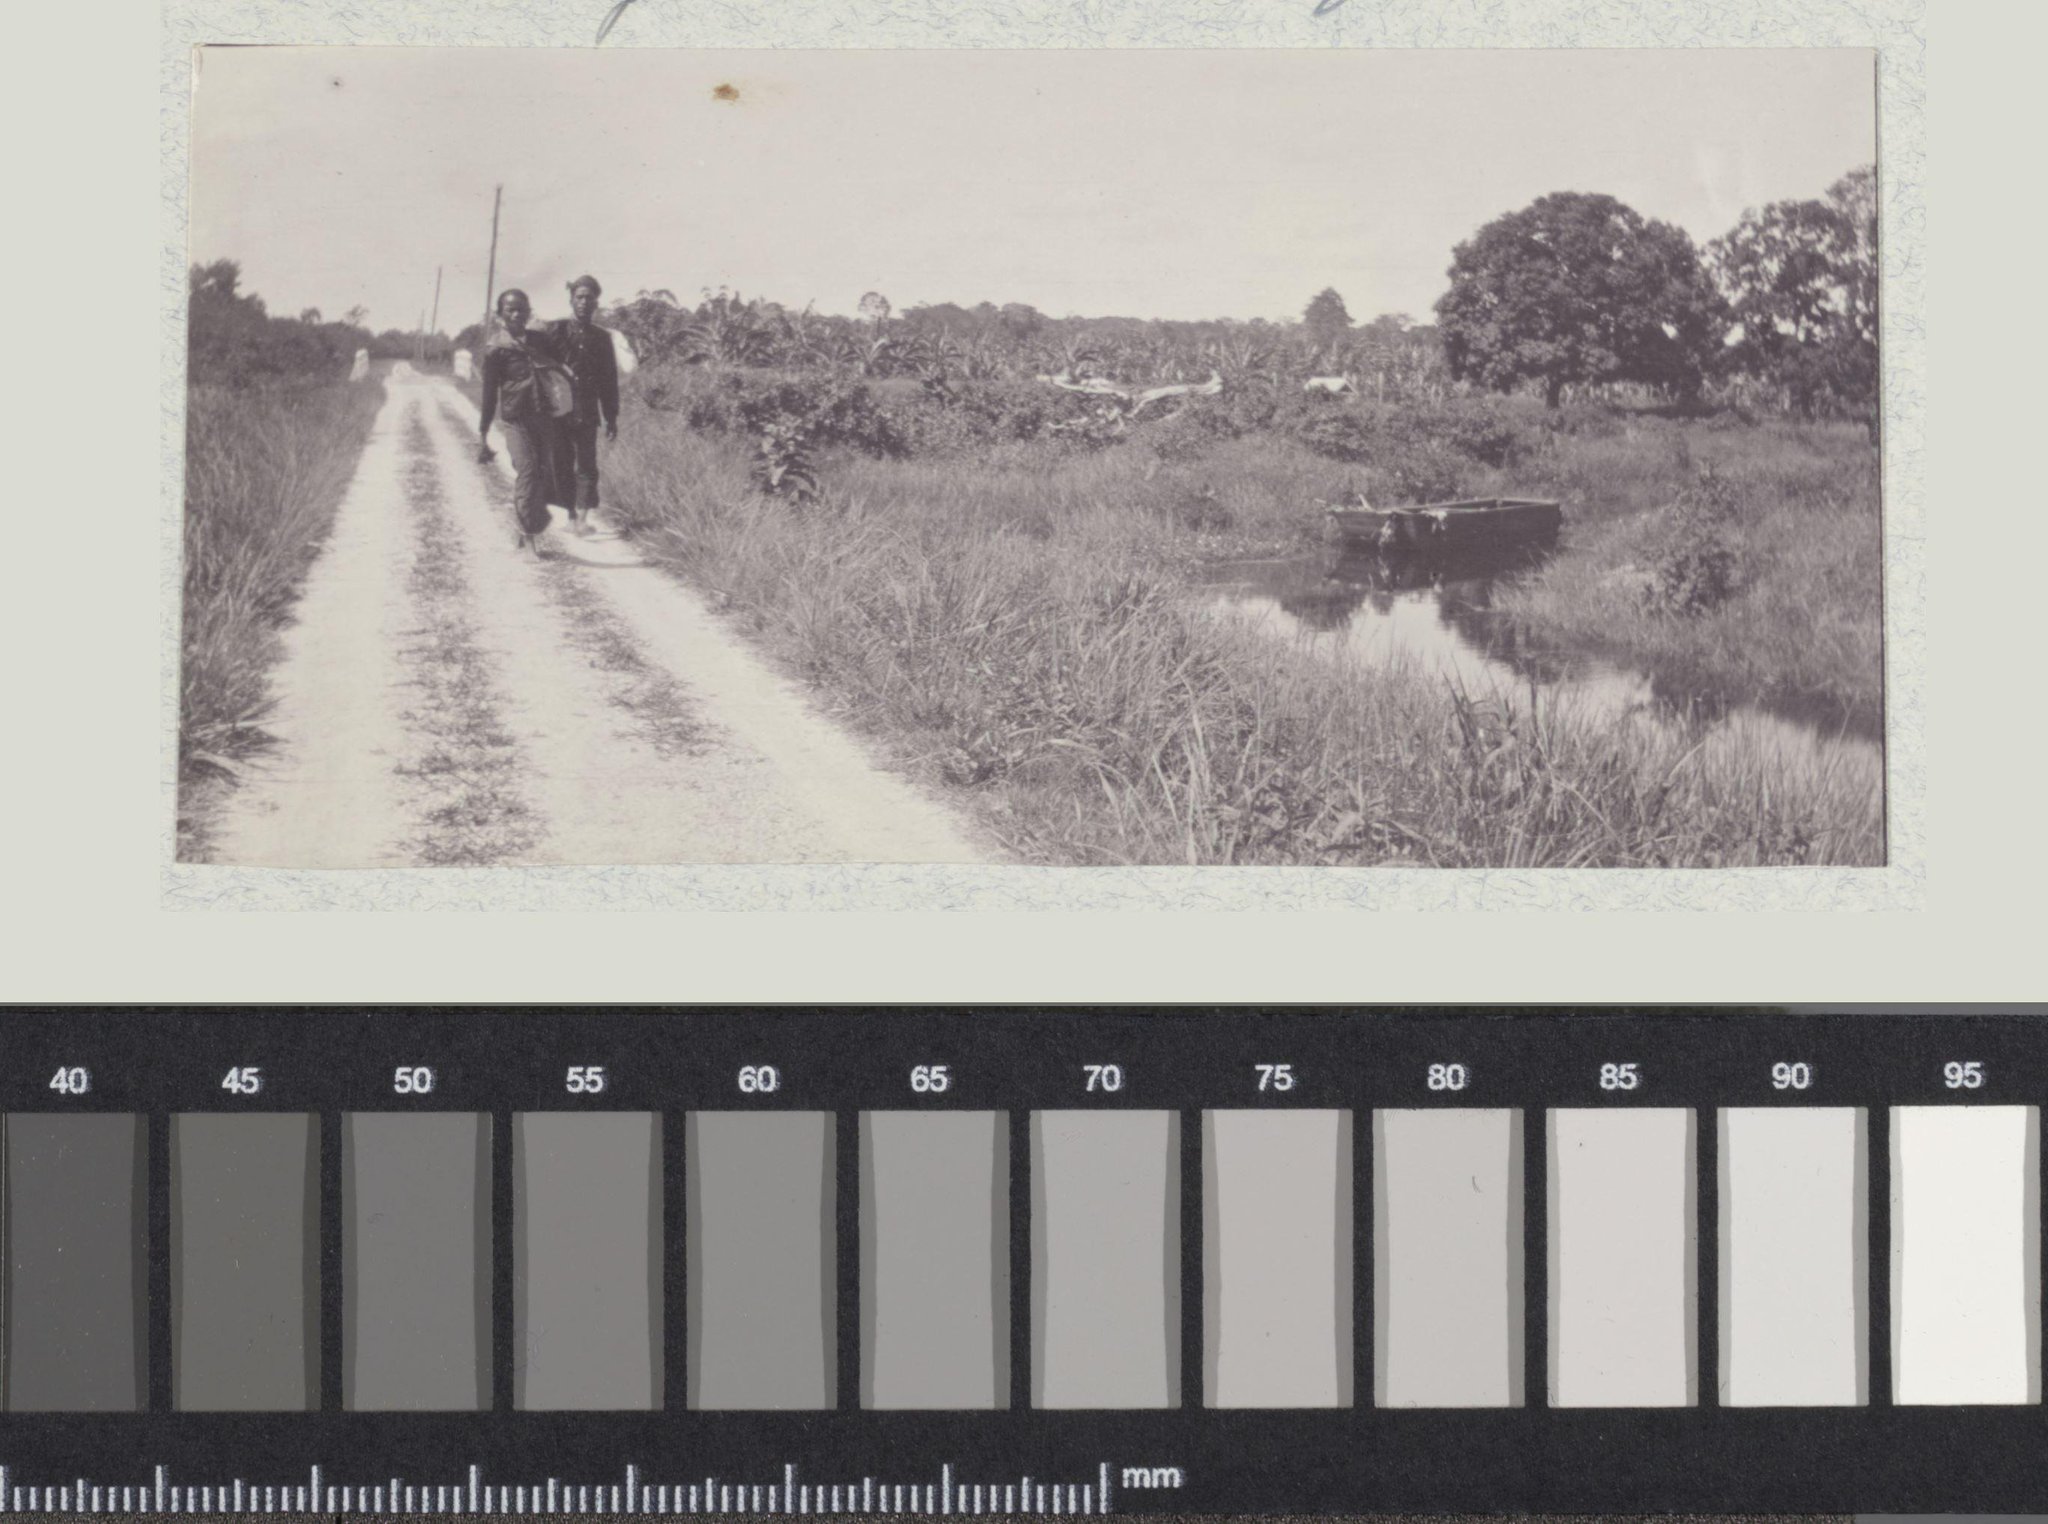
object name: photograph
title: Twee Javanen op een weg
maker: andries augustus boom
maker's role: amateurfotograaf, handelaar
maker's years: 1878-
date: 1911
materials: photographic support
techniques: photography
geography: suriname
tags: suriname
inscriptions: inscription: ‘weg naar "morgenstond"’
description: Twee Javanen, man en vrouw, lopend over een landweg, 1911. Onderweg naar Plantage Morgenstond. Onderdeel van het fotoalbum van de familie Boom-Gonggrijp in Suriname en Curaçao.